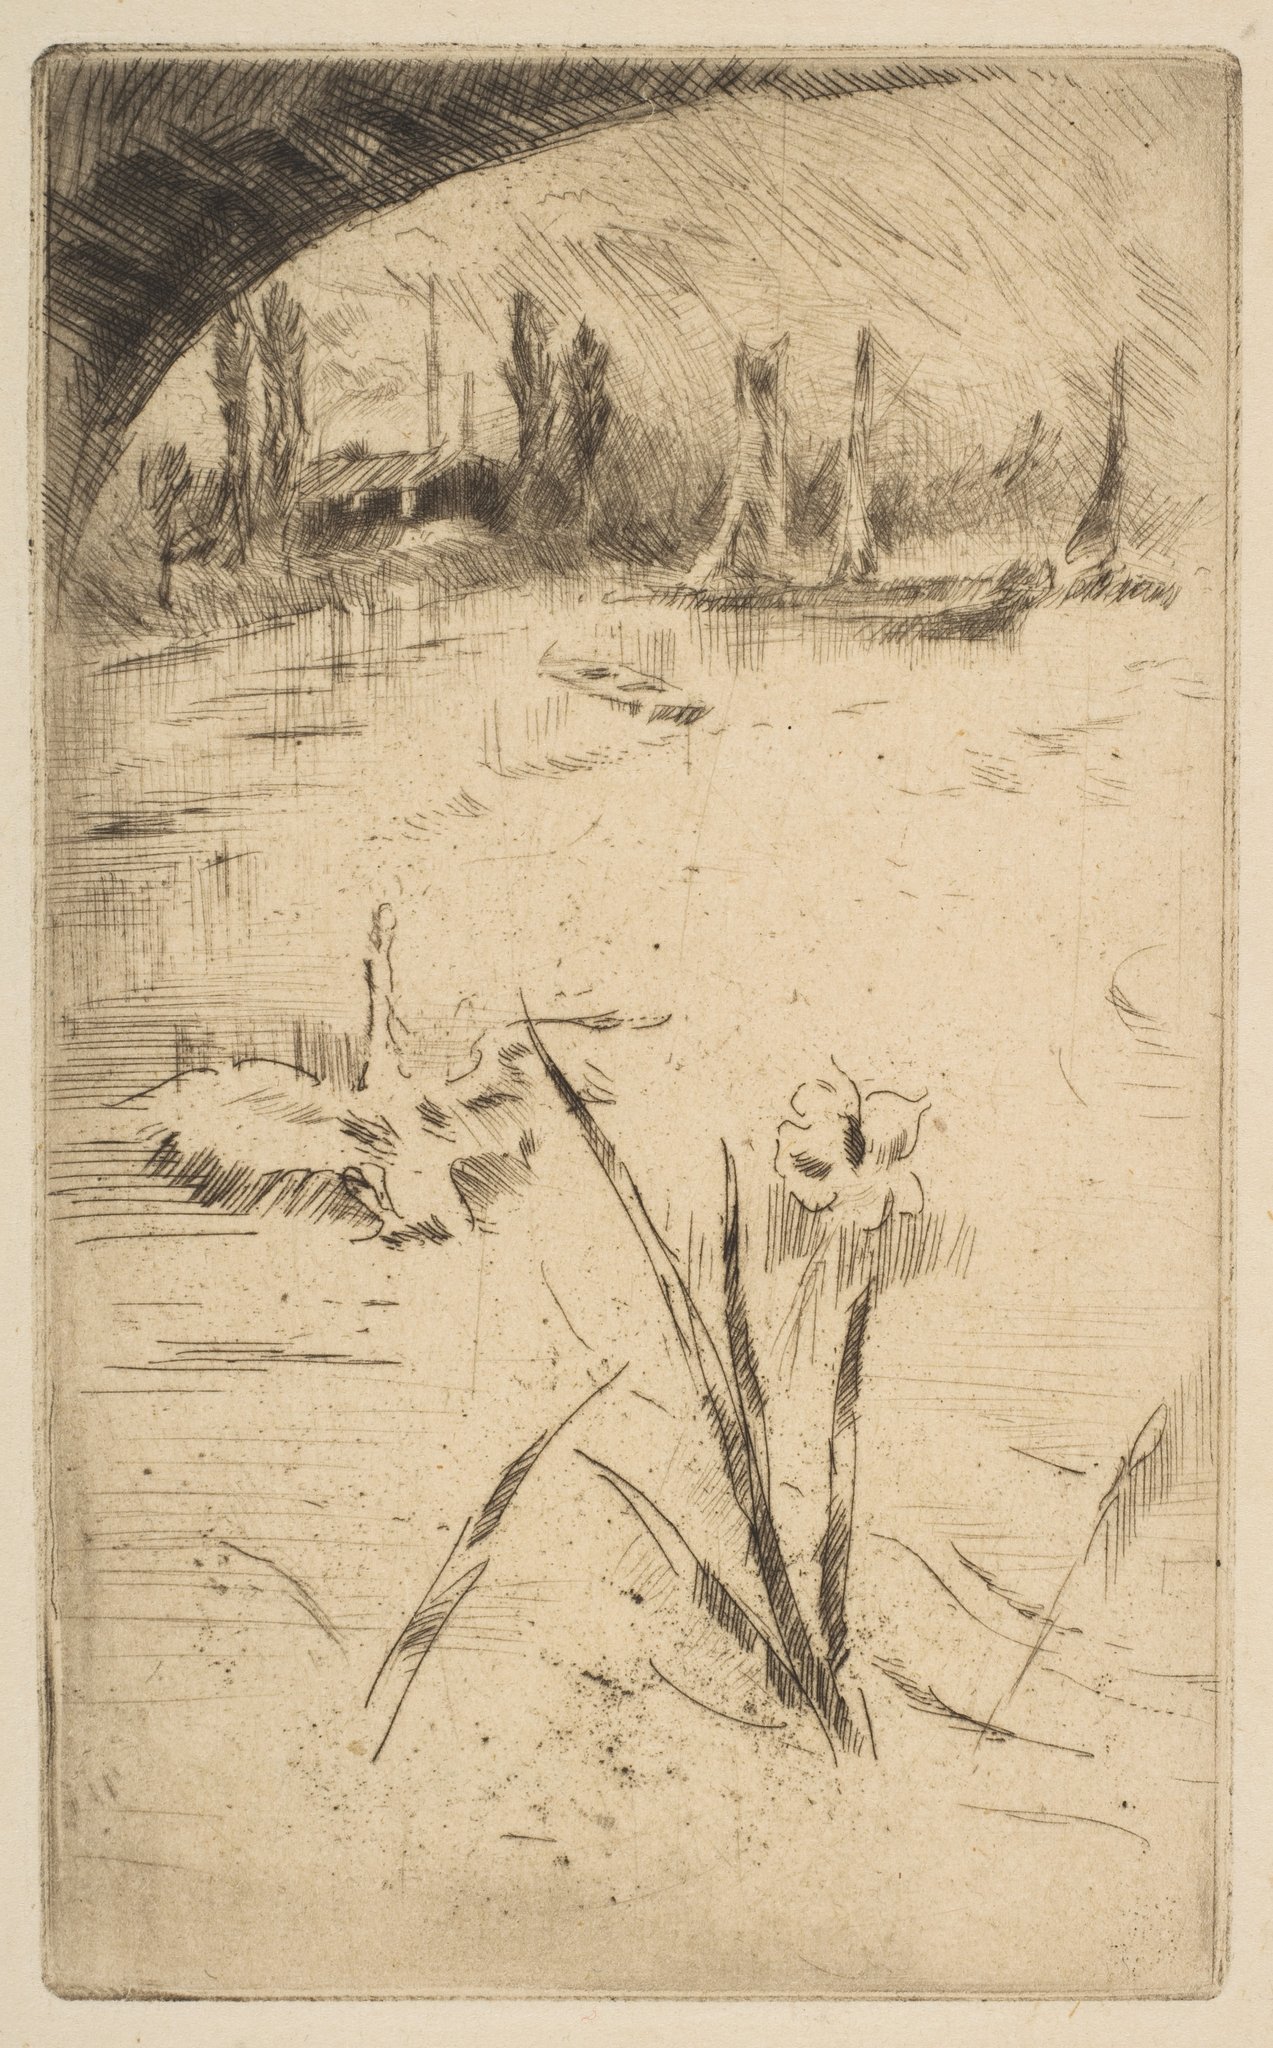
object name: print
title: Swan and Iris (sketch after Cecil Lawson's "Swan and Iris")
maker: james mcneill whistler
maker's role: artist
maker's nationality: american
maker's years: 1834-1903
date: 1883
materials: ink, paper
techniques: drypoint, etching, printing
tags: swans,flowers,london